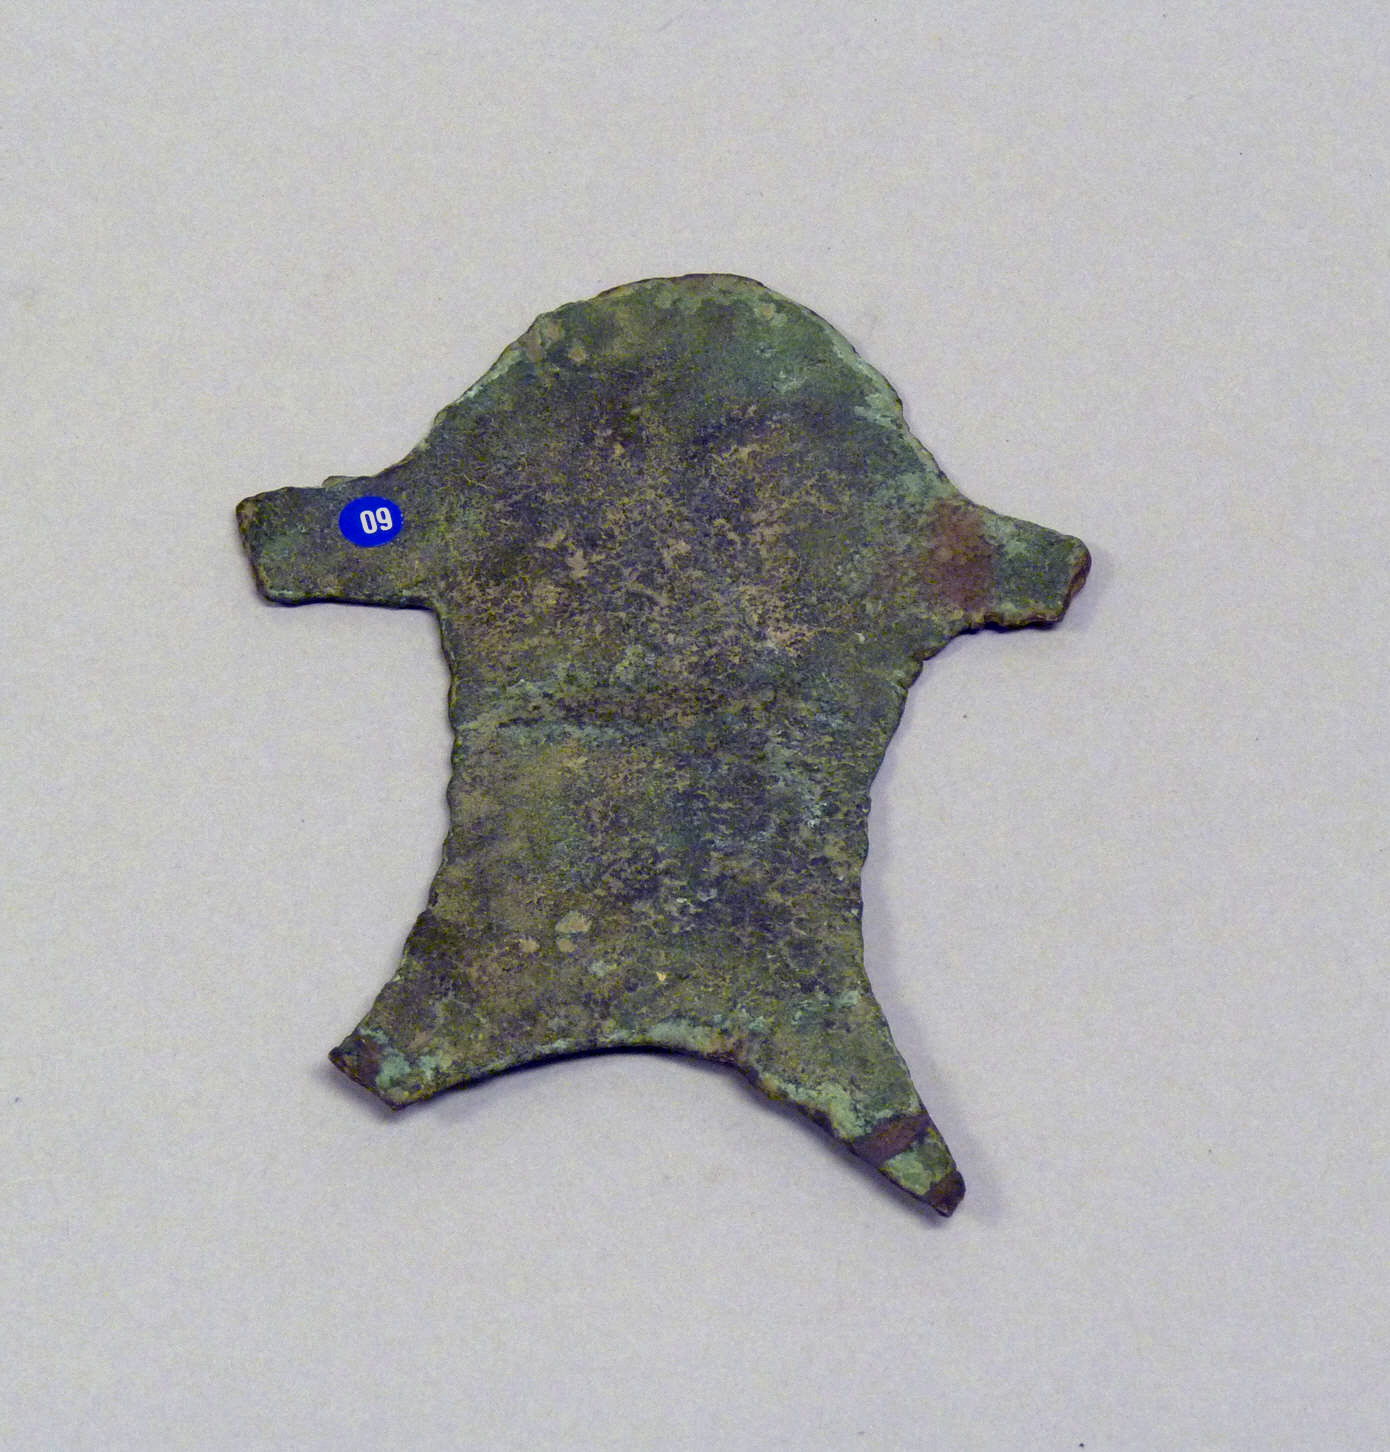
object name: anthropomorph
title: Eccentric Anthropomorph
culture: nepali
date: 1500-500 BCE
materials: copper